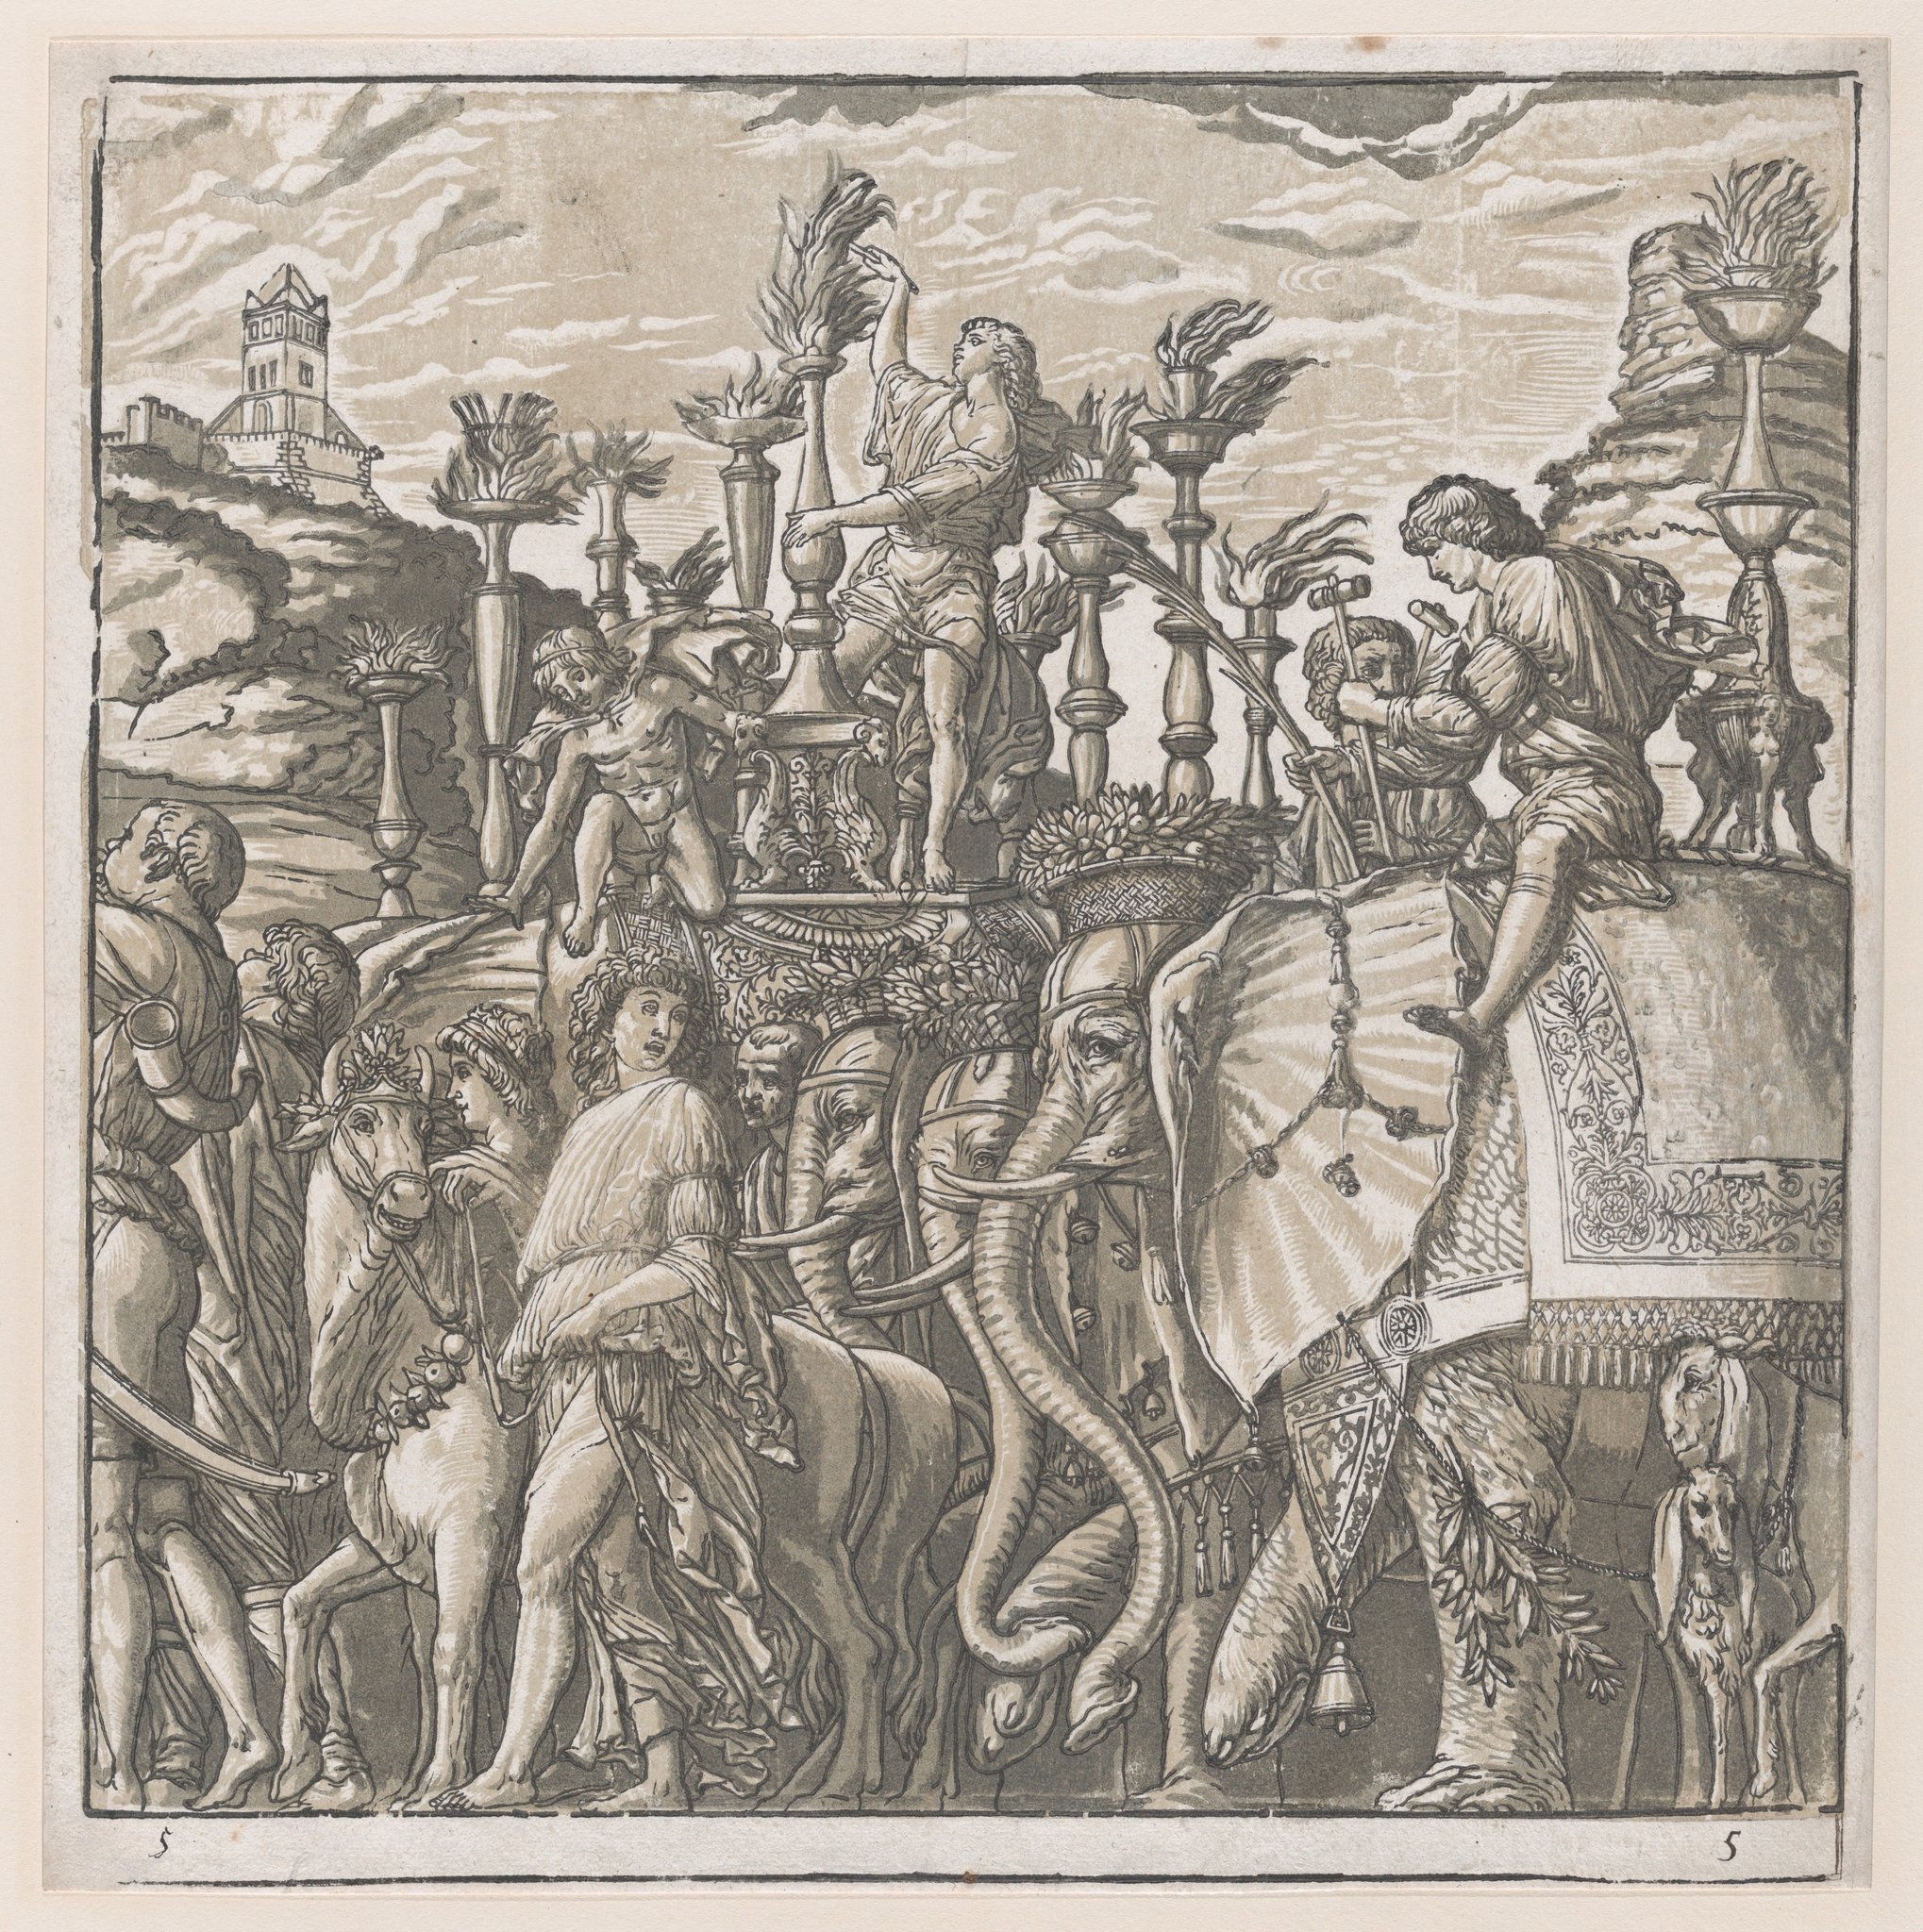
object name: print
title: Sheet 5: Elephants, from "The Triumph of Julius Caesar"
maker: andrea andreani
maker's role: artist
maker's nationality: italian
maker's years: 1558-1629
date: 1599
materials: ink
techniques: woodcut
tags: men,cows,elephants